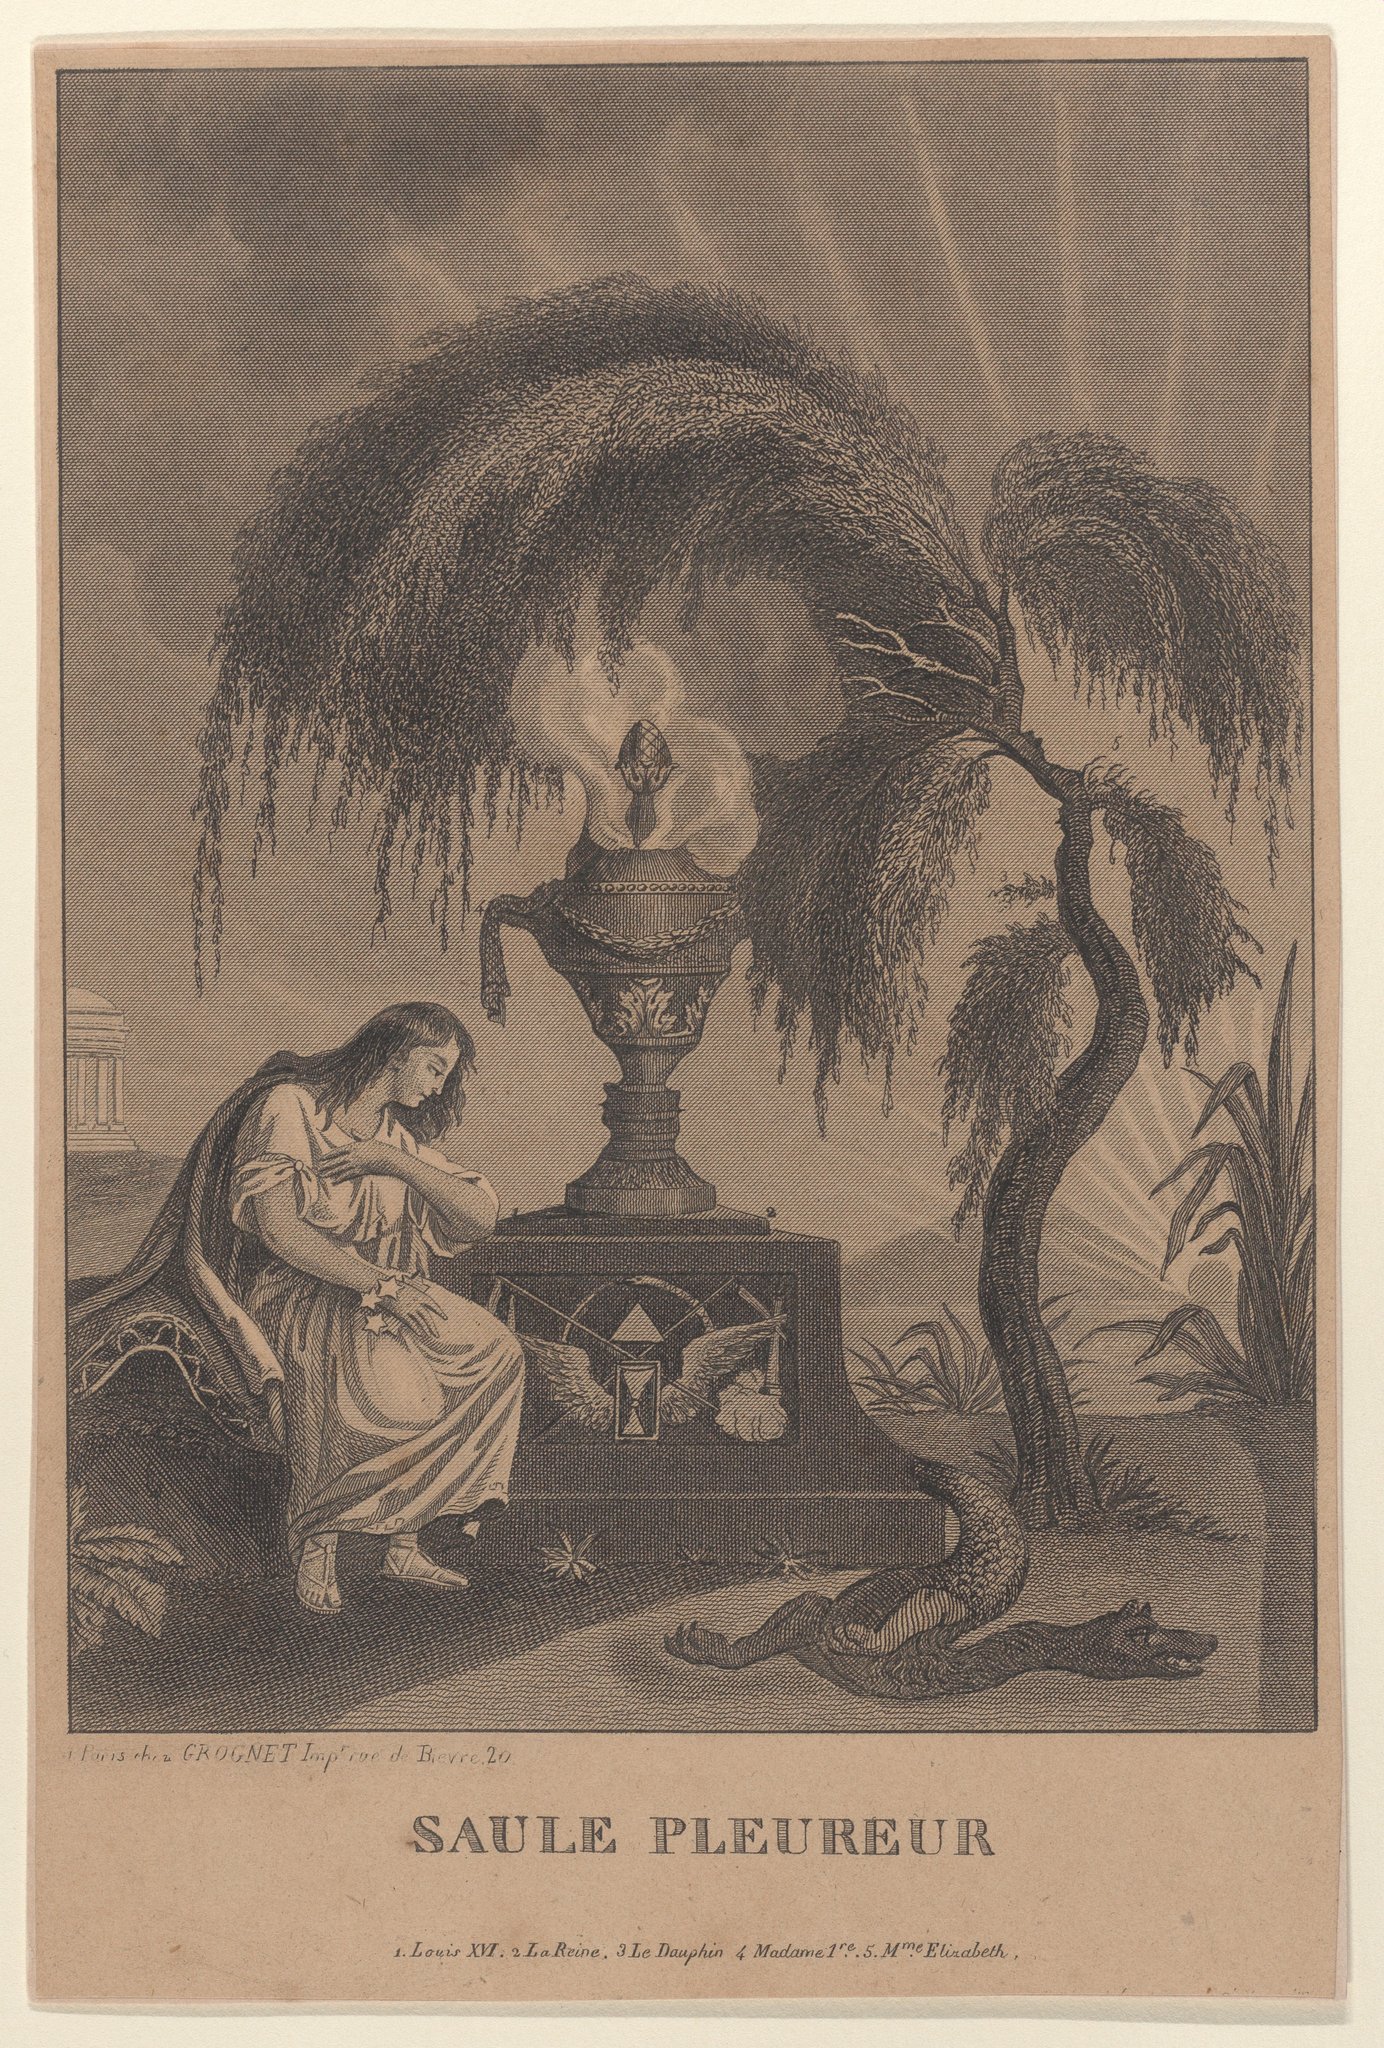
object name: print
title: The Weeping Willow with hidden silhouettes of the Royal family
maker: Anonymous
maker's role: artist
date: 1795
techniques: engraving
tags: french revolution,louis xvi,marie antoinette,trees